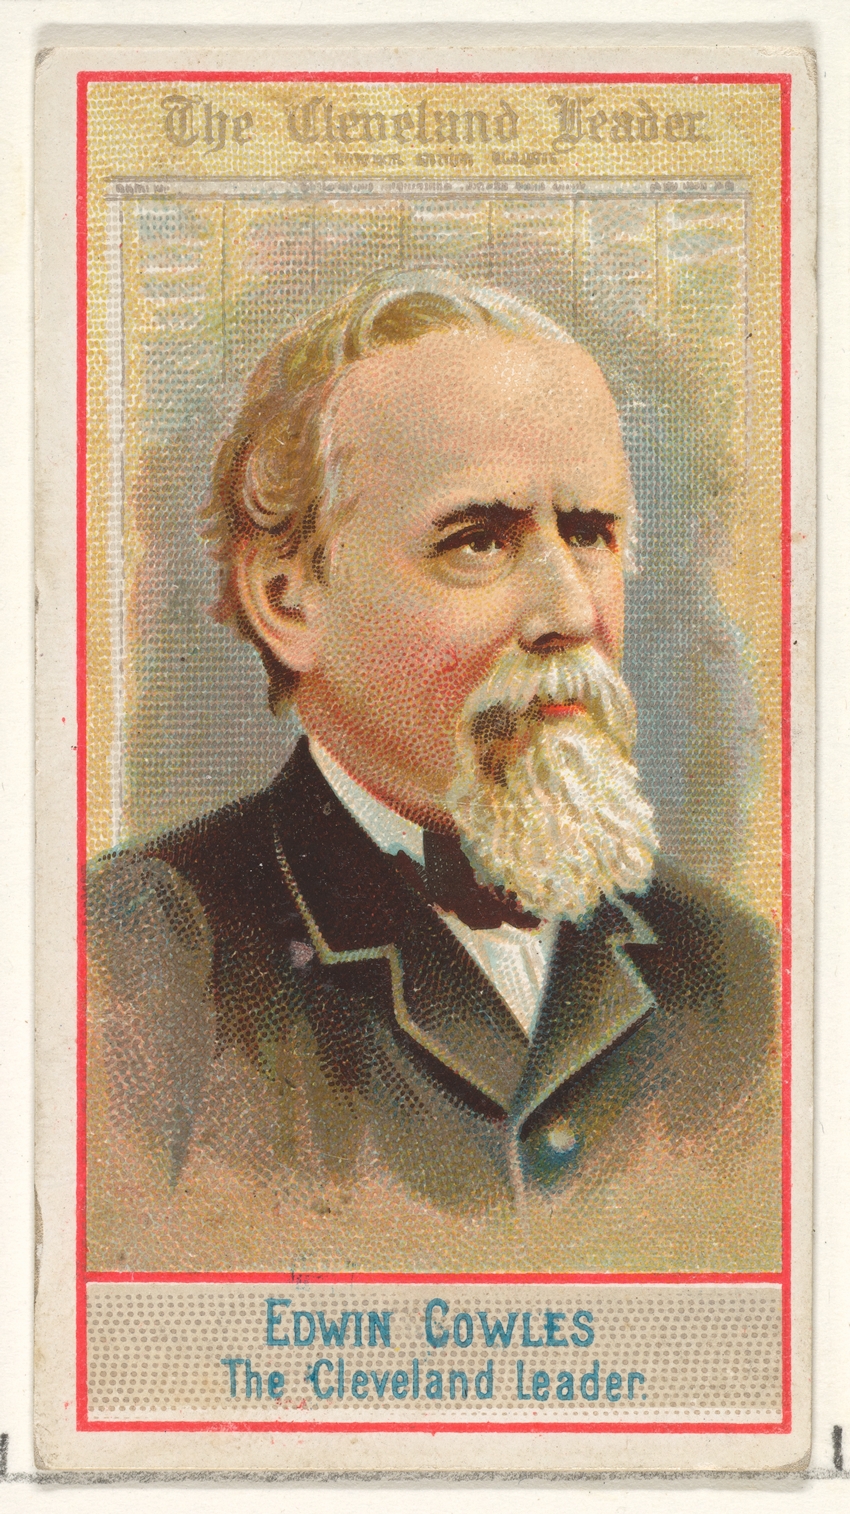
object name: print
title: Edwin Cowles, The Cleveland Leader, from the American Editors series (N1) for Allen & Ginter Cigarettes Brands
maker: allen & ginter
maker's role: publisher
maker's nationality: american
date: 1887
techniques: color lithograph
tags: men,portraits